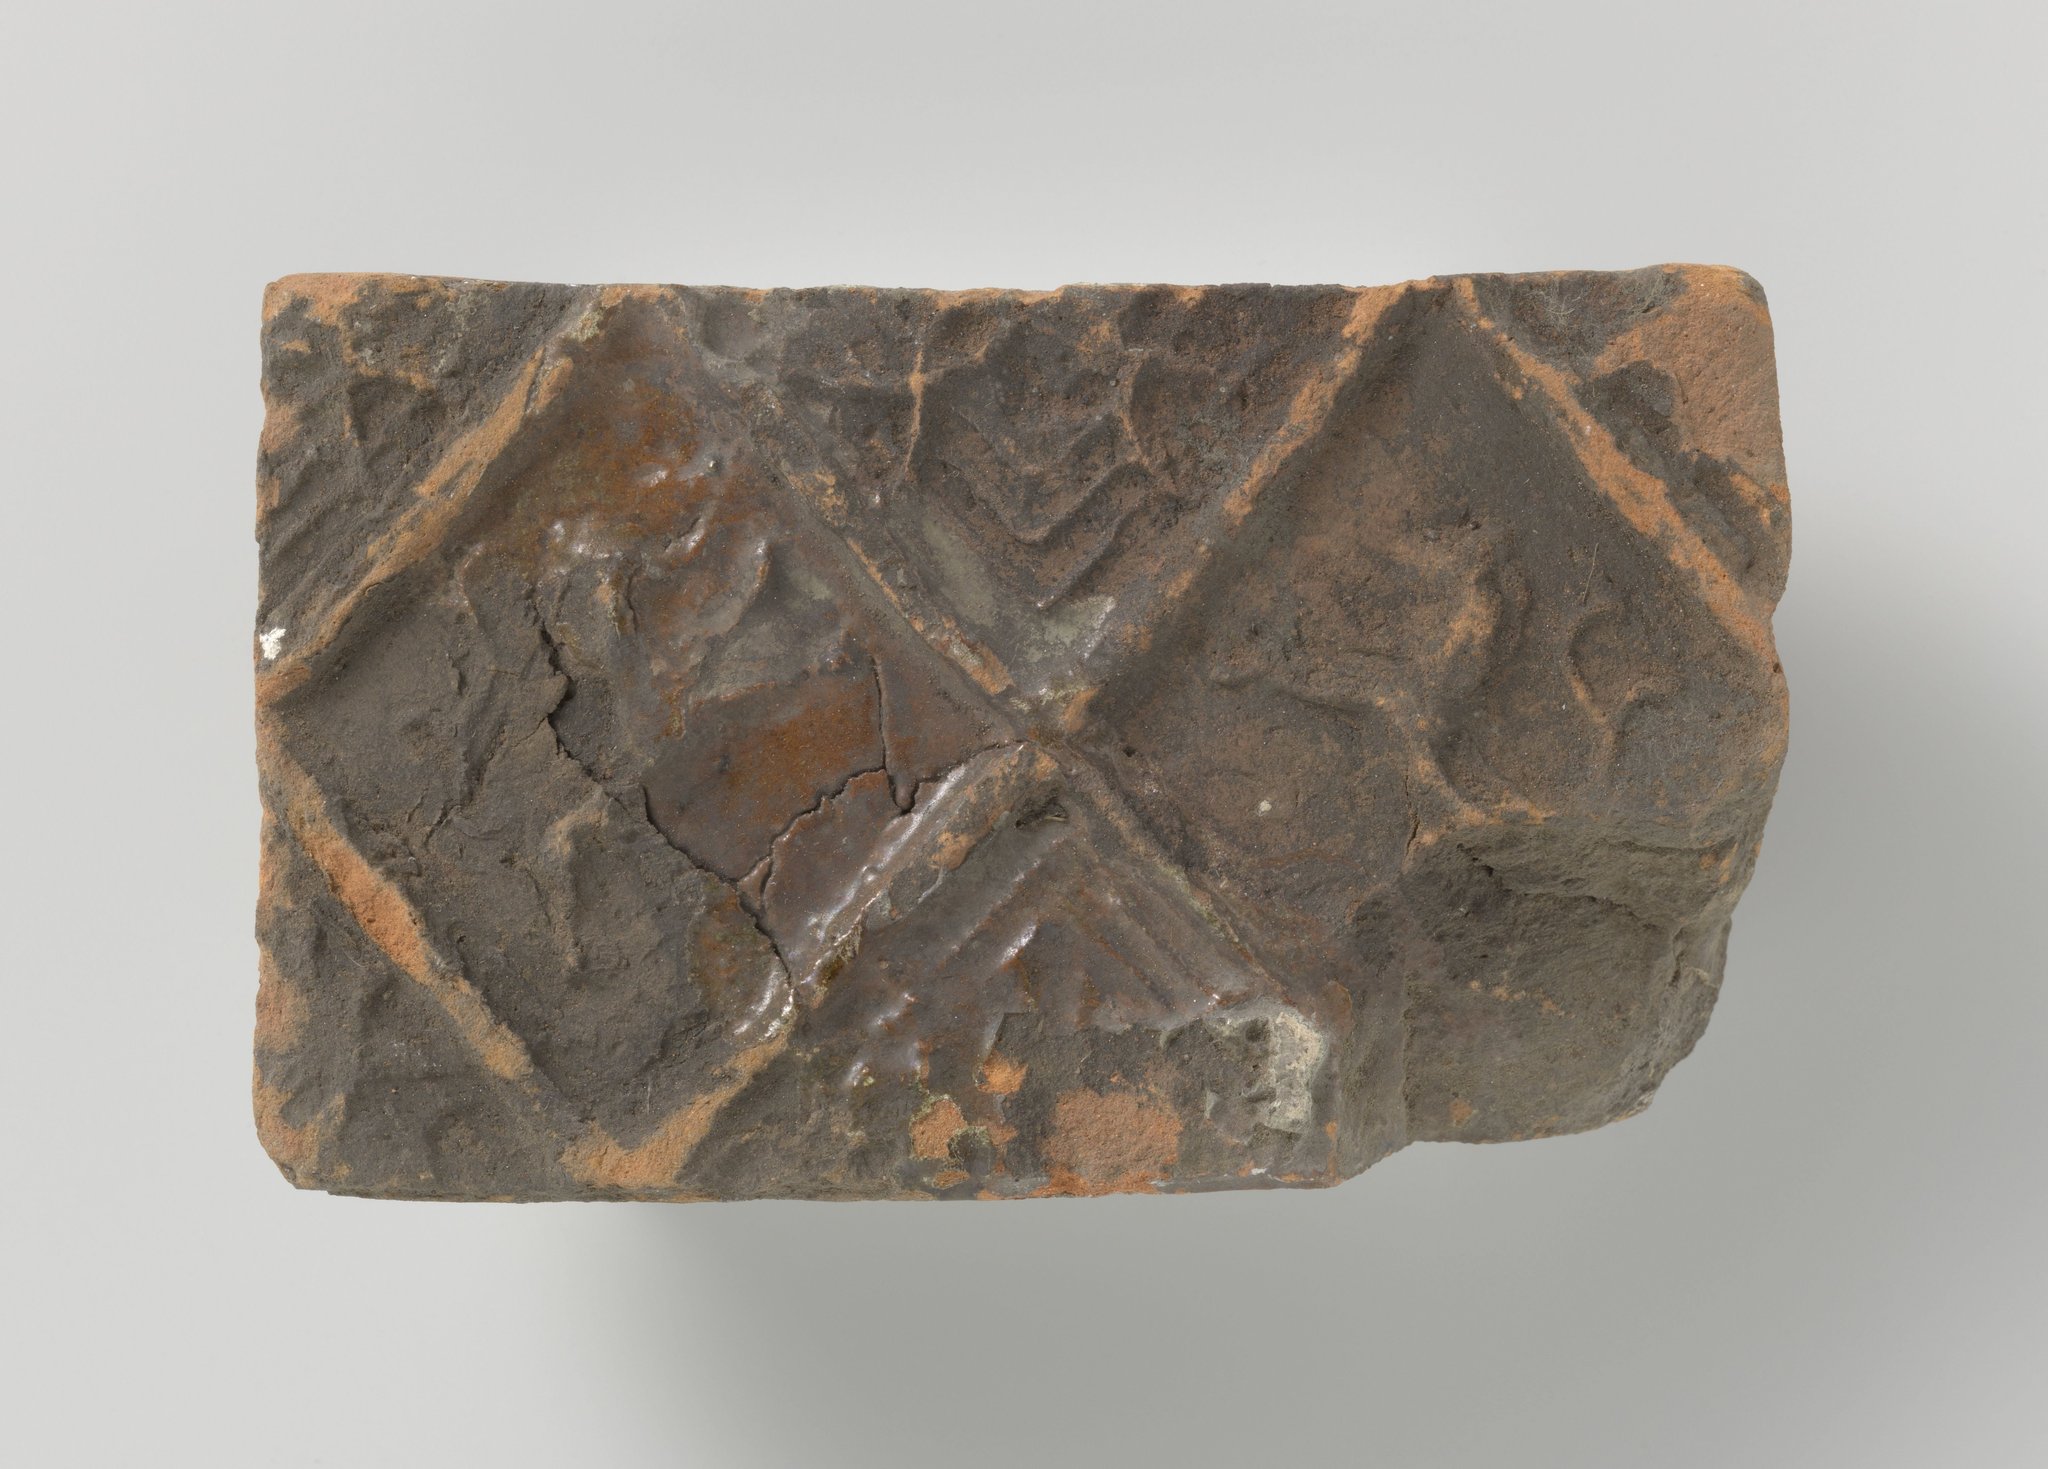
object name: hearthstone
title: Haardsteen met voorstelling van twee klimmende leeuwen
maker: Anonymous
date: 1600-1625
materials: earthenware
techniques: vitrification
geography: southern netherlands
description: Haardsteen met voorstelling van twee twee klimmende leeuwen, geplaatst in geprofileerde ruit. De halve ruiten aan de boven- en onderkant zijn opgevuld met bladmotief.